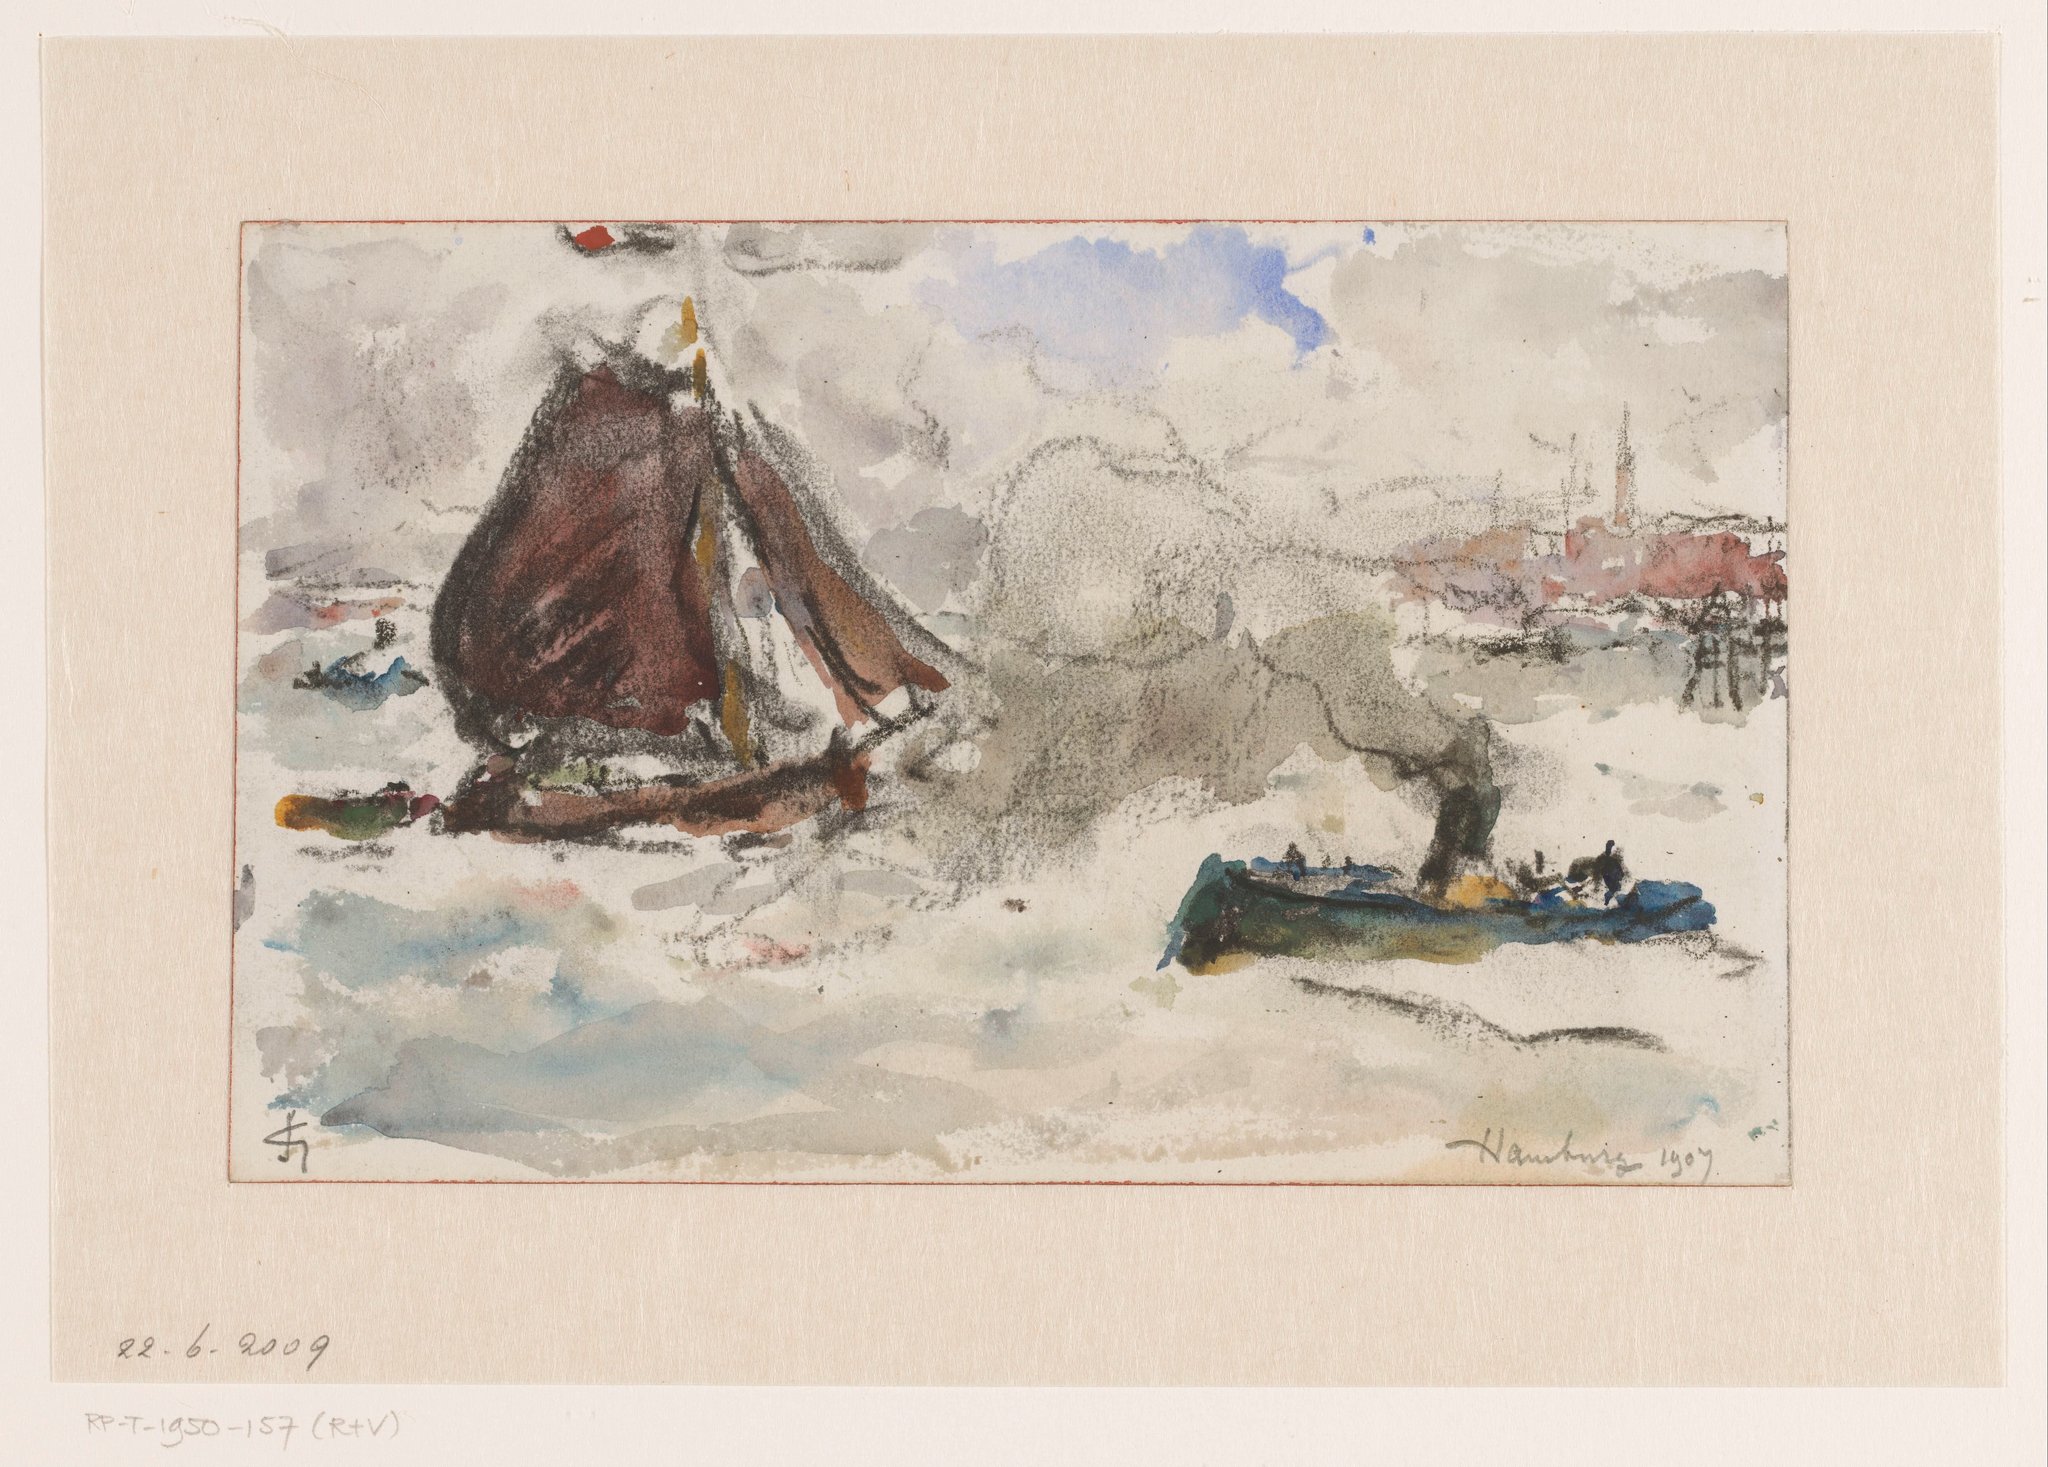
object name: drawing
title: Woelig water voor de haven van Hamburg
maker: carel nicolaas storm van s-gravesande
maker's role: draughtsman, print maker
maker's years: 1841-1924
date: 1907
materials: chalk, paper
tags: harbour, germany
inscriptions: date: ‘1907’